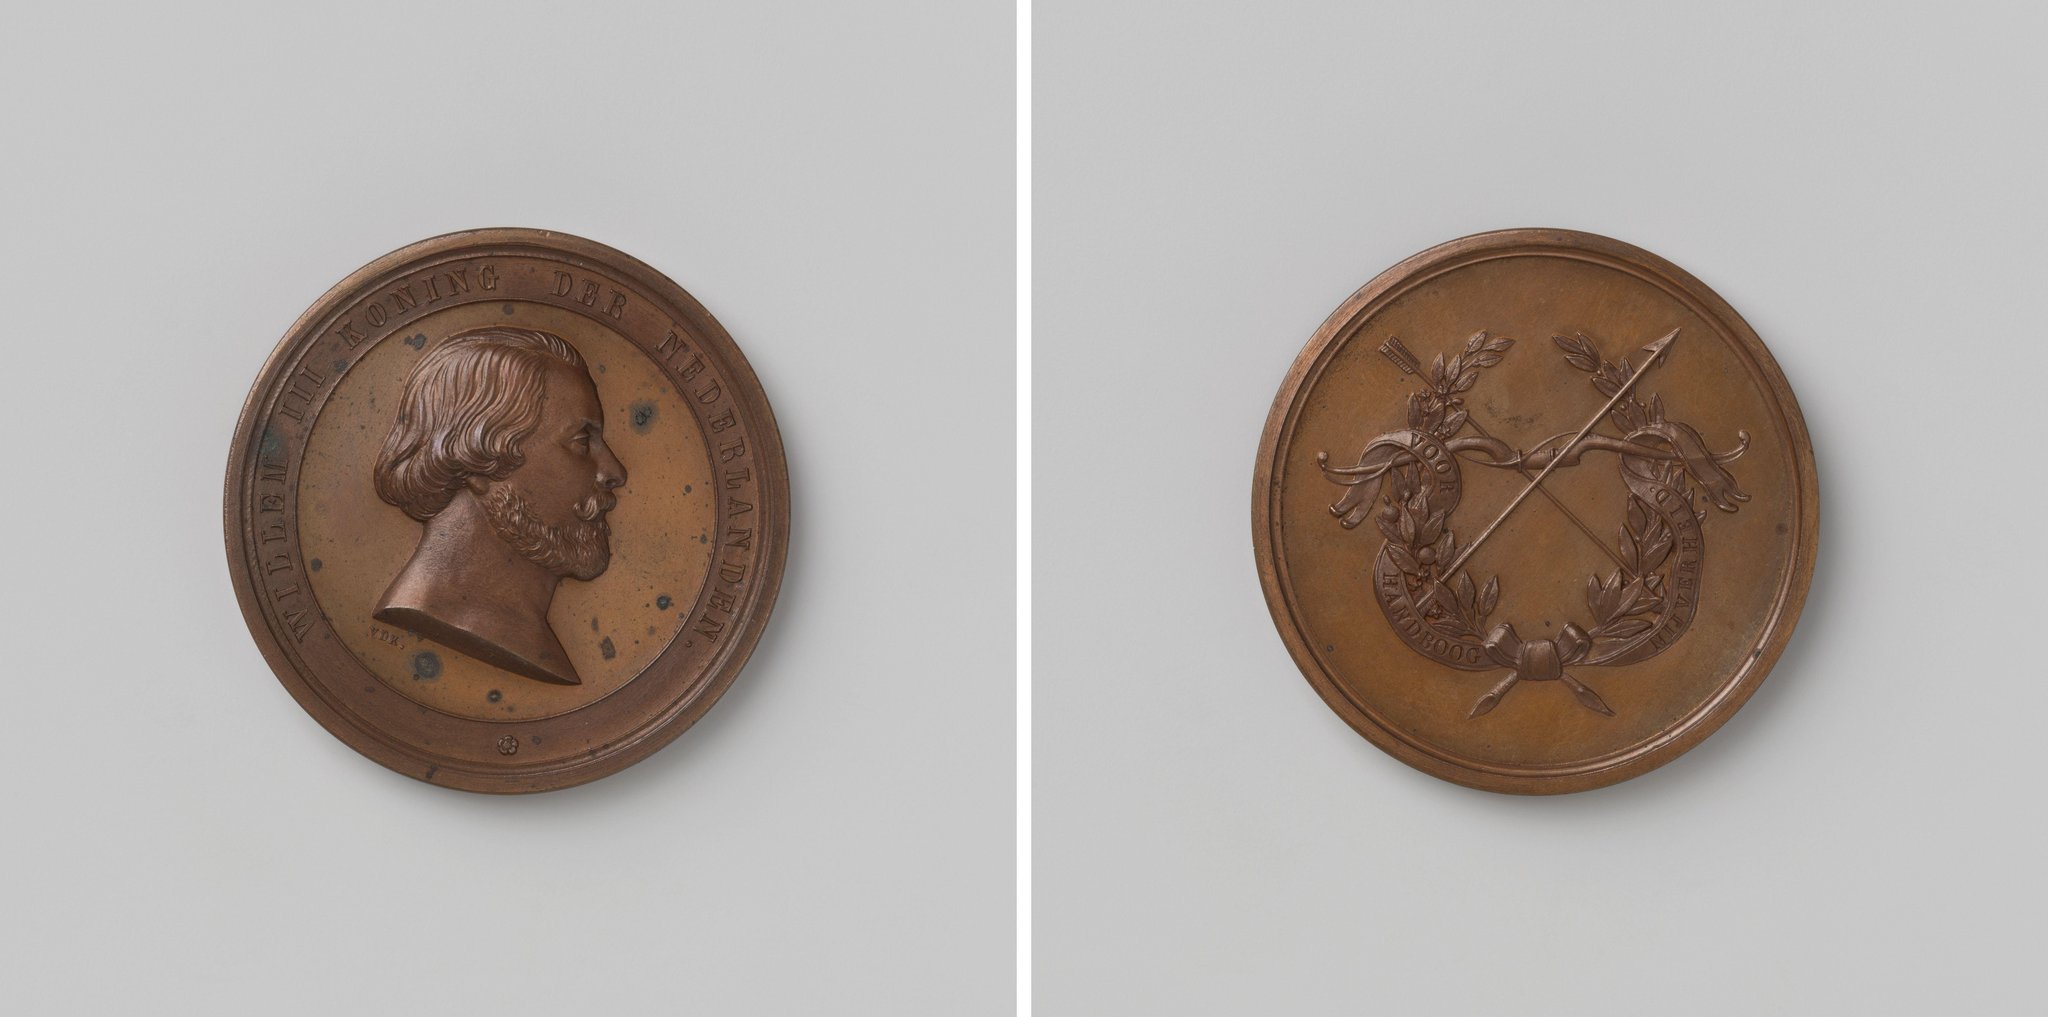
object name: marksman medal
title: Handboog Nijverheid, penning ter ere van Willem III, koning der Nederlanden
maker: david van der kellen (1804-1879)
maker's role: die cutter, draughtsman, print maker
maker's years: 1804-1879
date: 1851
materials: bronze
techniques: striking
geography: utrecht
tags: brussels, willem iii (koning der nederlanden), netherlands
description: Bronzen penning. Voorzijde: borststuk man binnen omschrift. Keerzijde: twee gekruiste pijlen op een handboog binnen tot krans samengeboneden lauwer- en myrtetak, omwonden met lint met opschrift